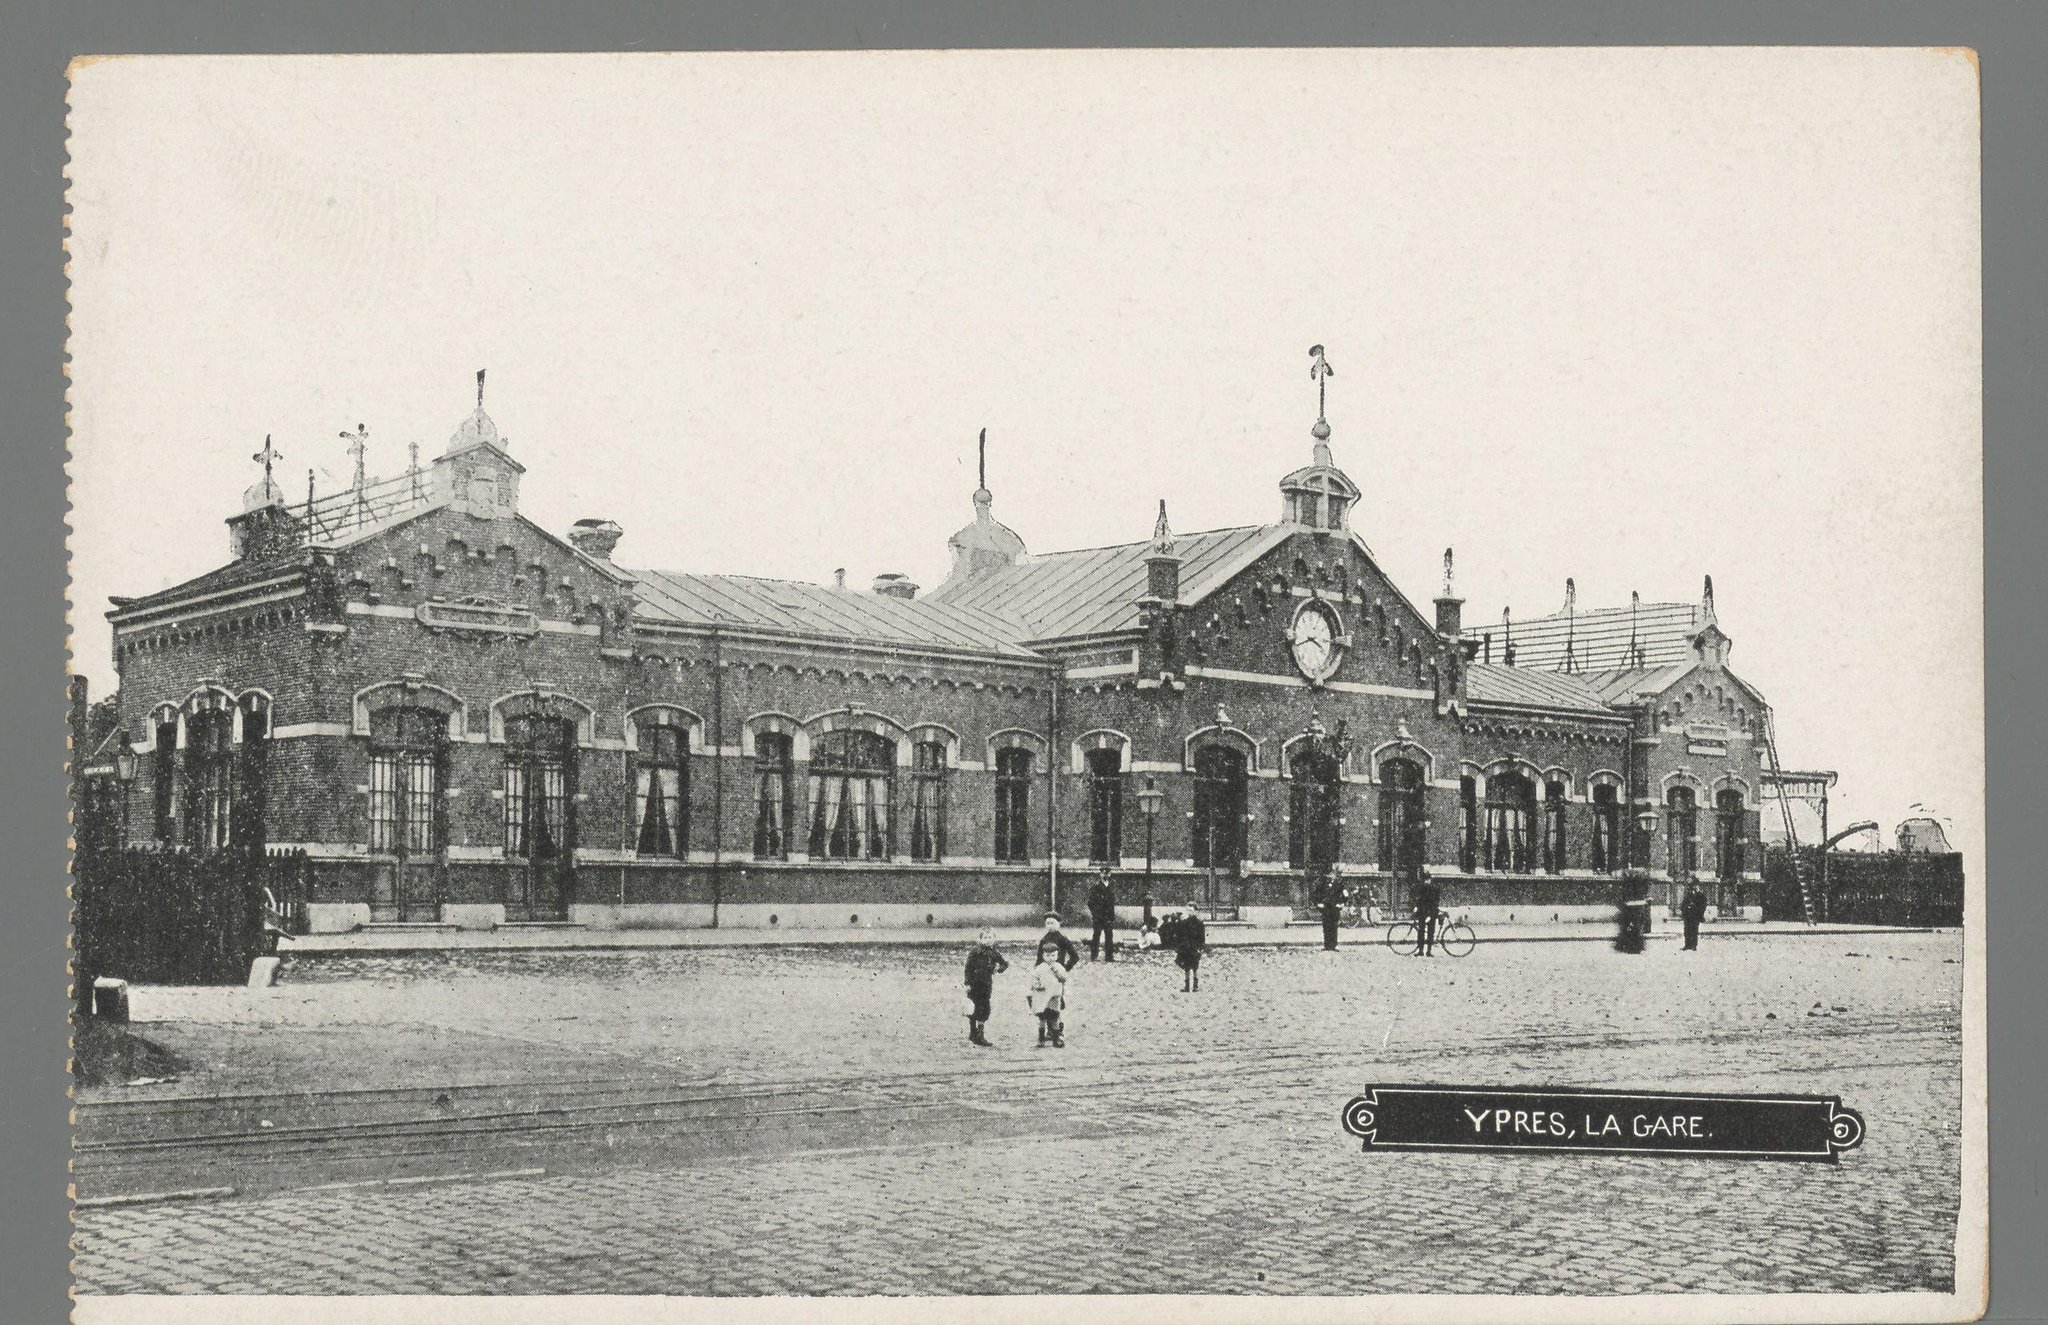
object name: ansichtkaart, prentbriefkaart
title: Ypres, la gare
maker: Anonymous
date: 1906-1918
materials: cardboard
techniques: autotype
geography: ieper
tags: station; shelter (railway, tramway), city-view, and landscape with man-made constructions (+ city(-scape) with figures, staffage)